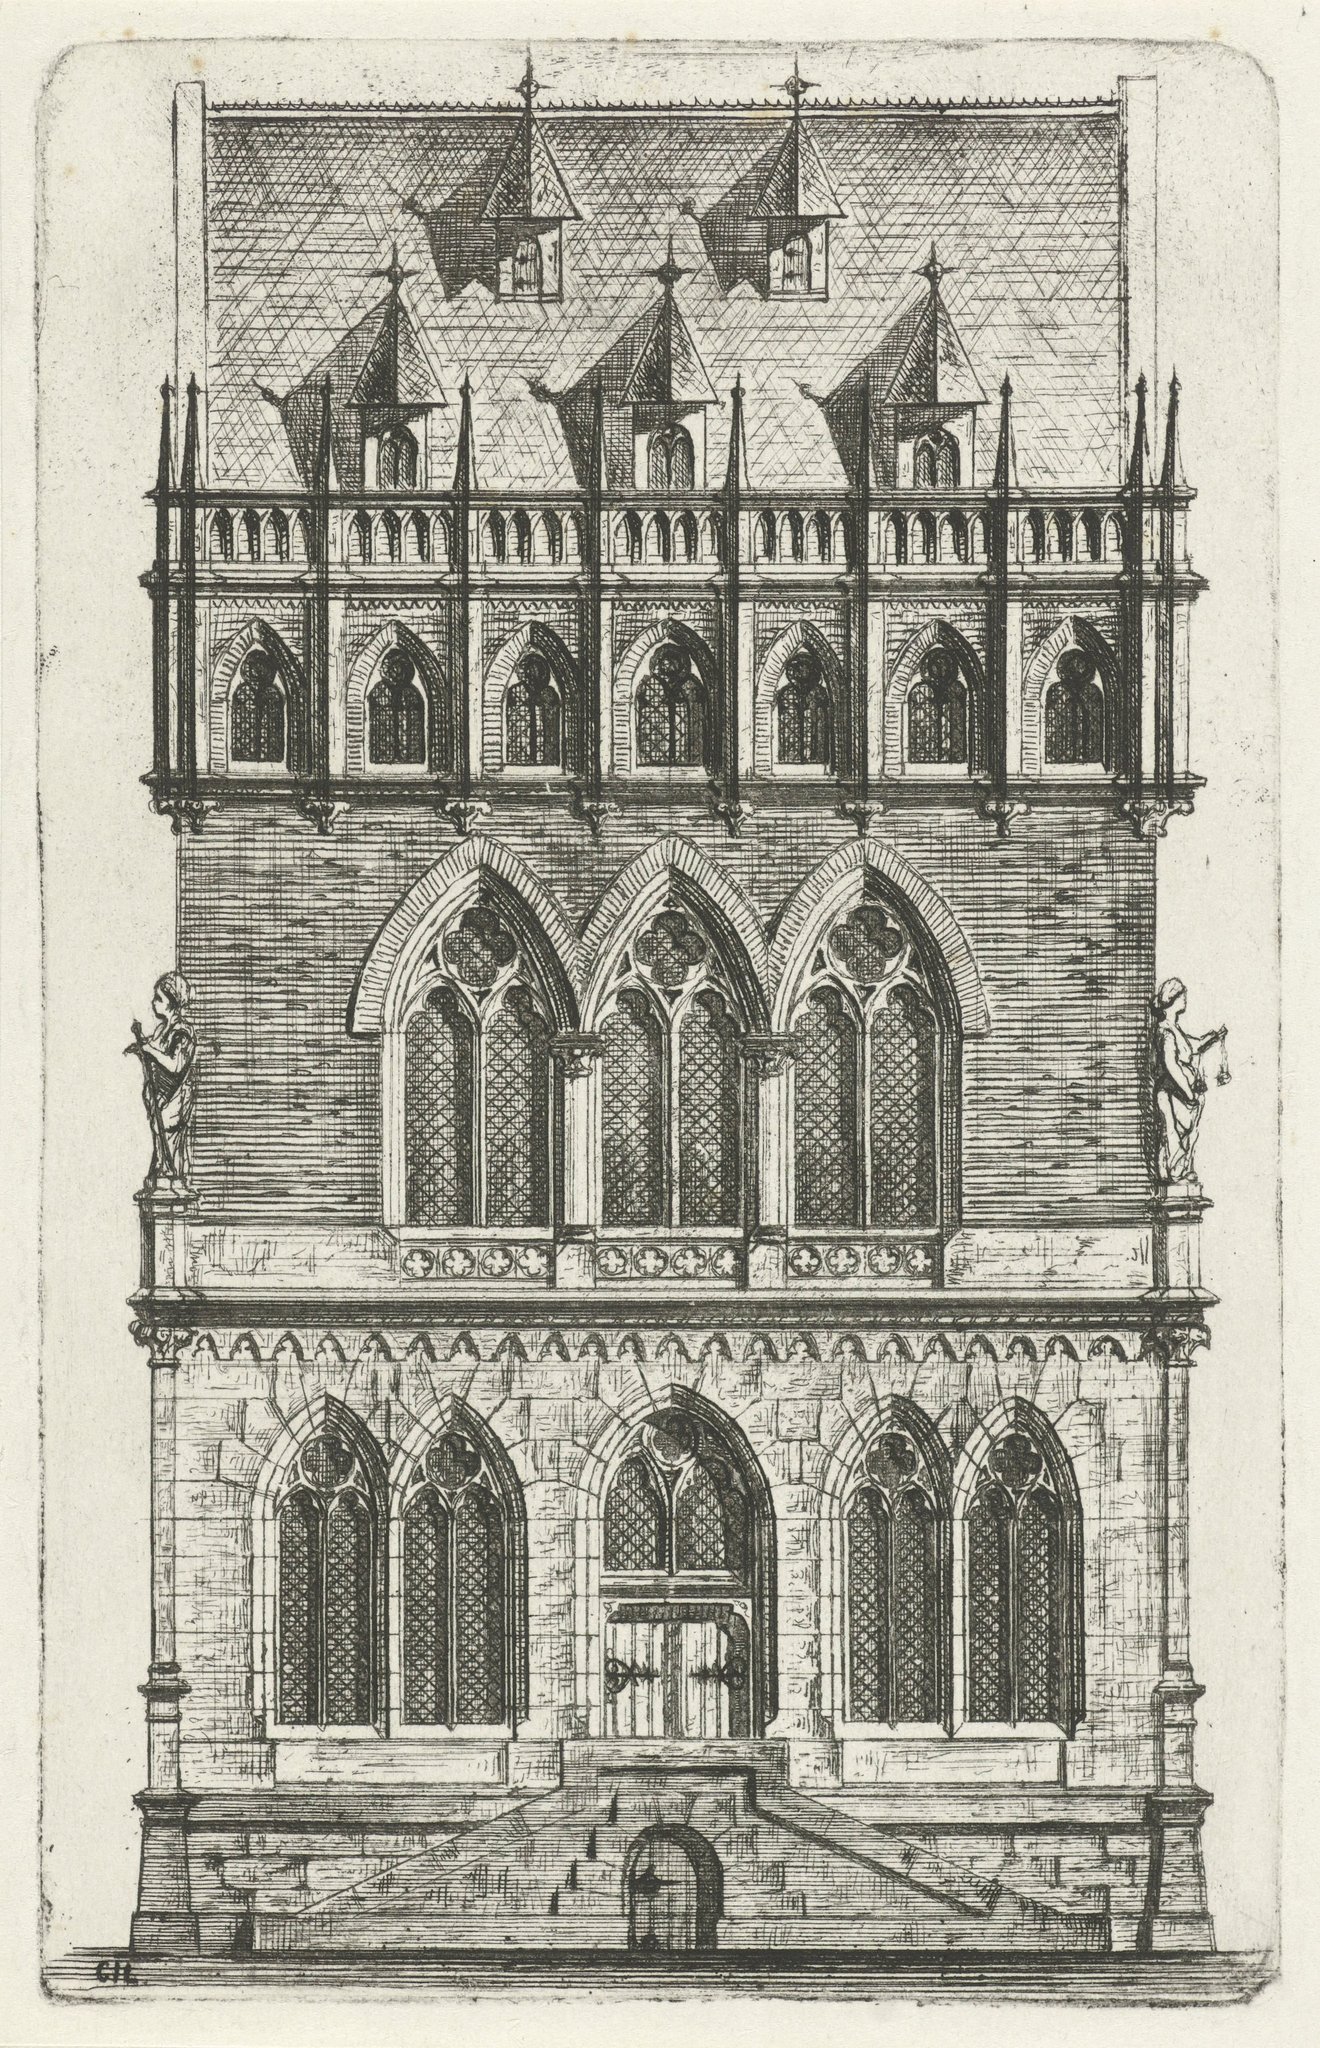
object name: print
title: Gotische gevel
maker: cornelis johan laarman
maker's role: print maker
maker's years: 1844-1889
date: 1854-1889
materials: paper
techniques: etching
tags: architecture (+ gothic art), architecture (+ relief ~ sculpture)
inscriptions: collector's mark: Lugt 2228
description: Vooraanzicht van een gotisch huis met aan weerszijden sculpturen.